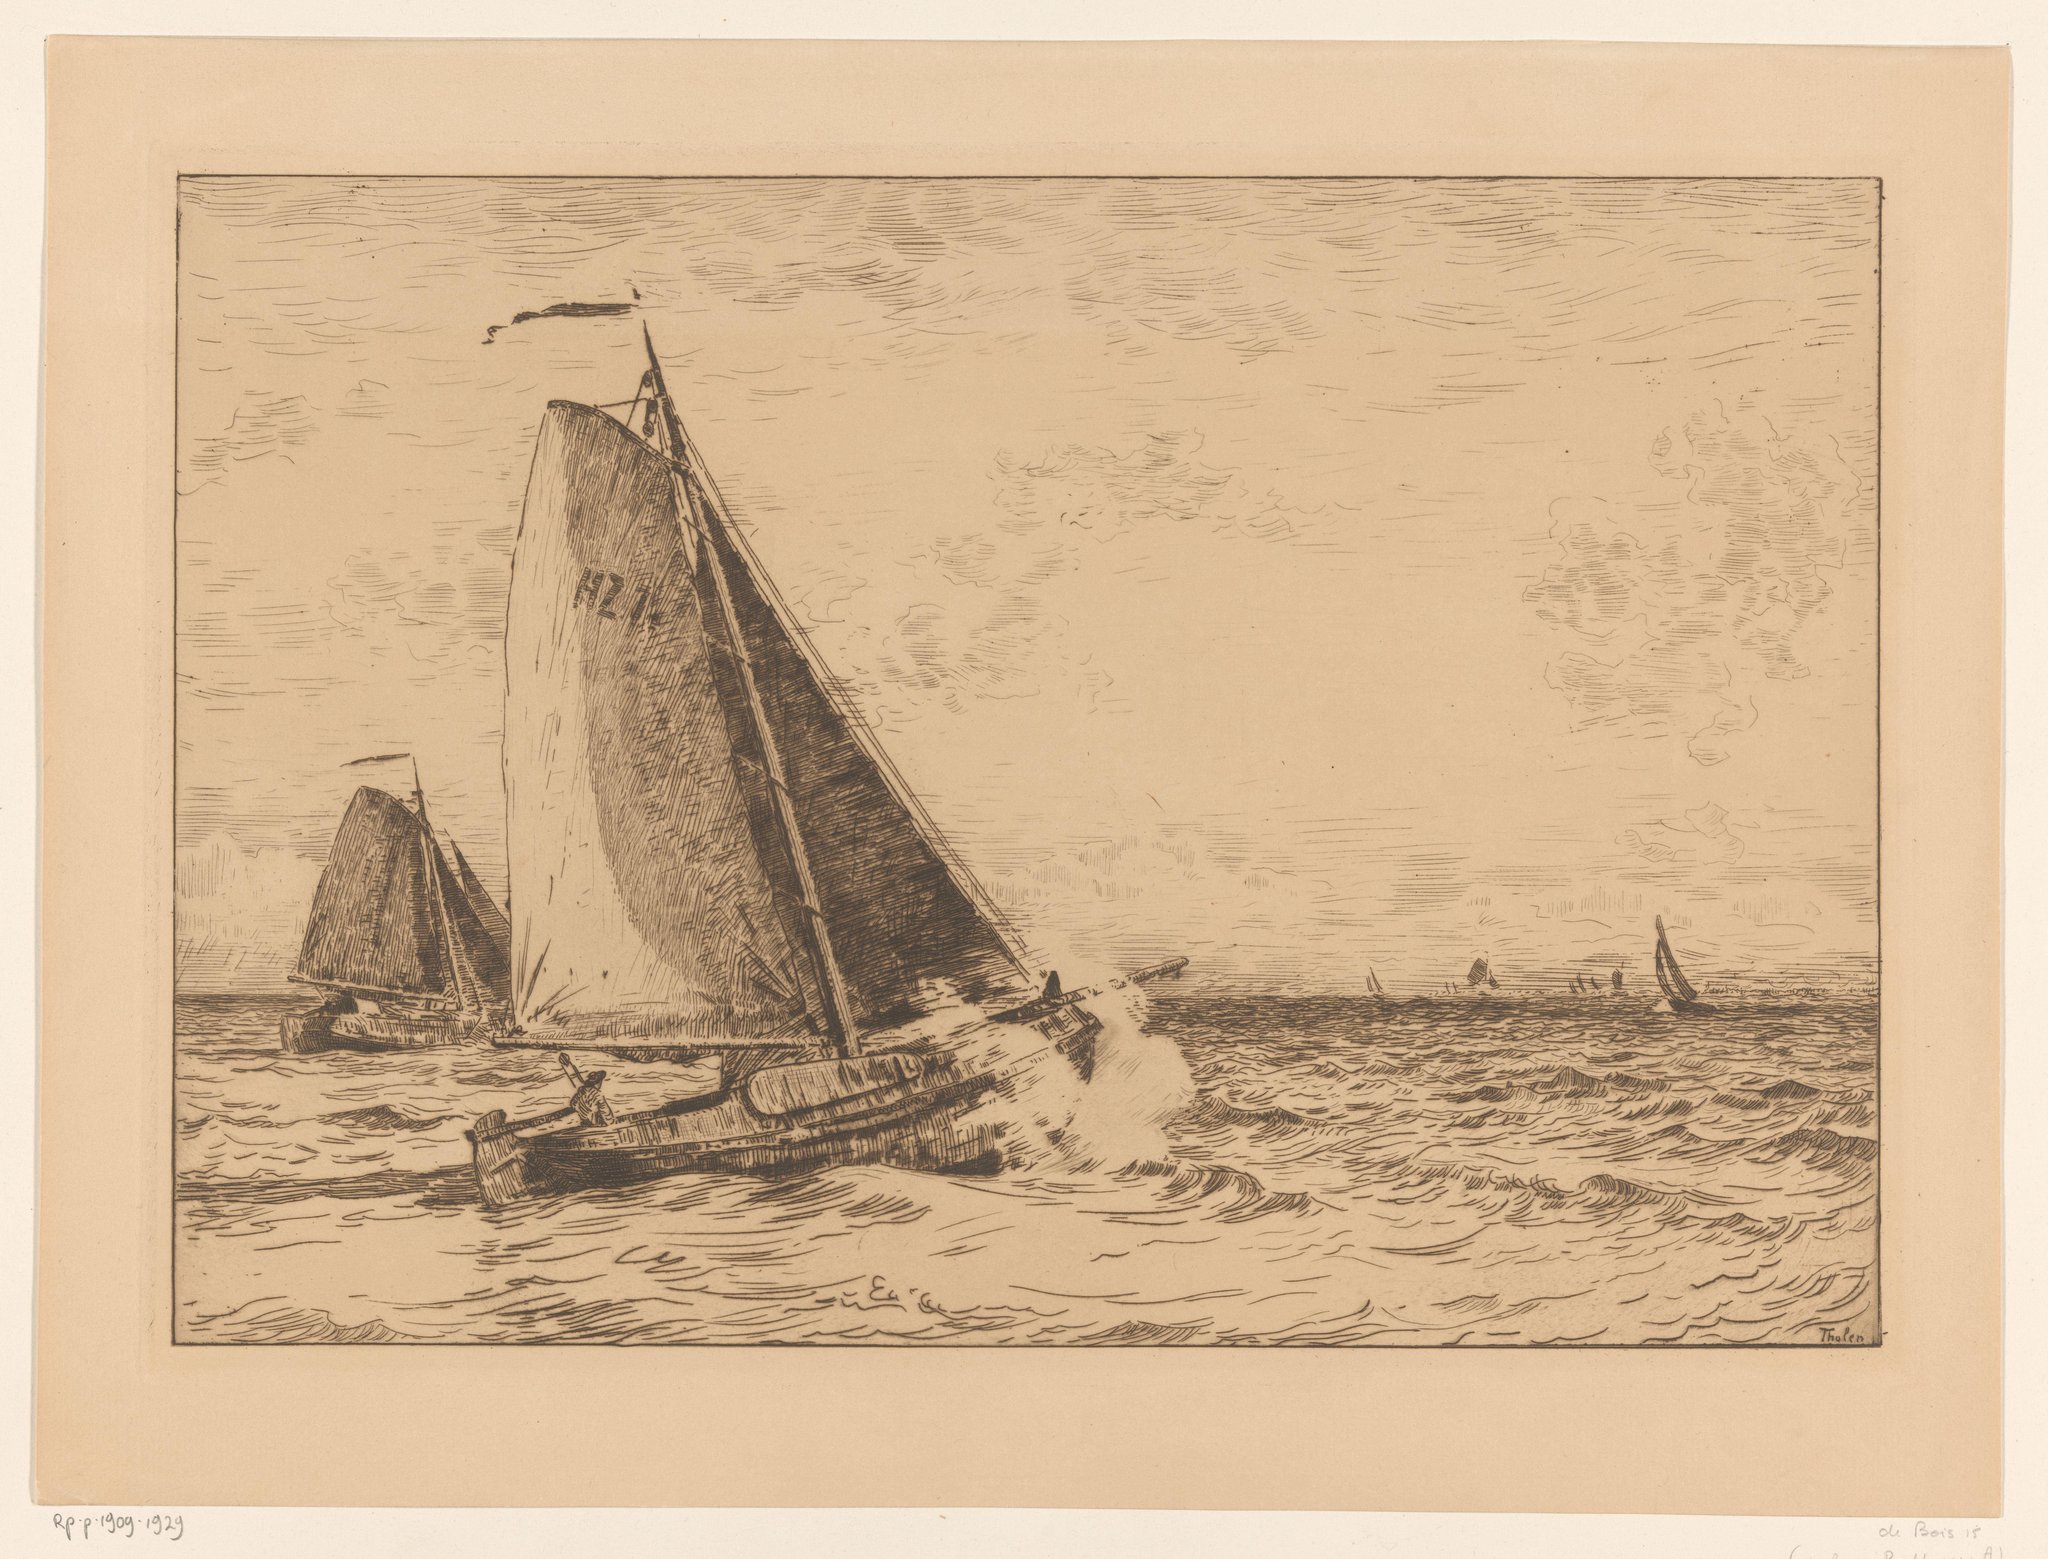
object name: print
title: Zee met zeilende botters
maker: willem bastiaan tholen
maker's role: draughtsman, painter, print maker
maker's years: 1860-1931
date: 1870-1909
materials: paper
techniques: etching, intaglio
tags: sailing-ship, sailing-boat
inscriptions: collector's mark: Lugt 2228